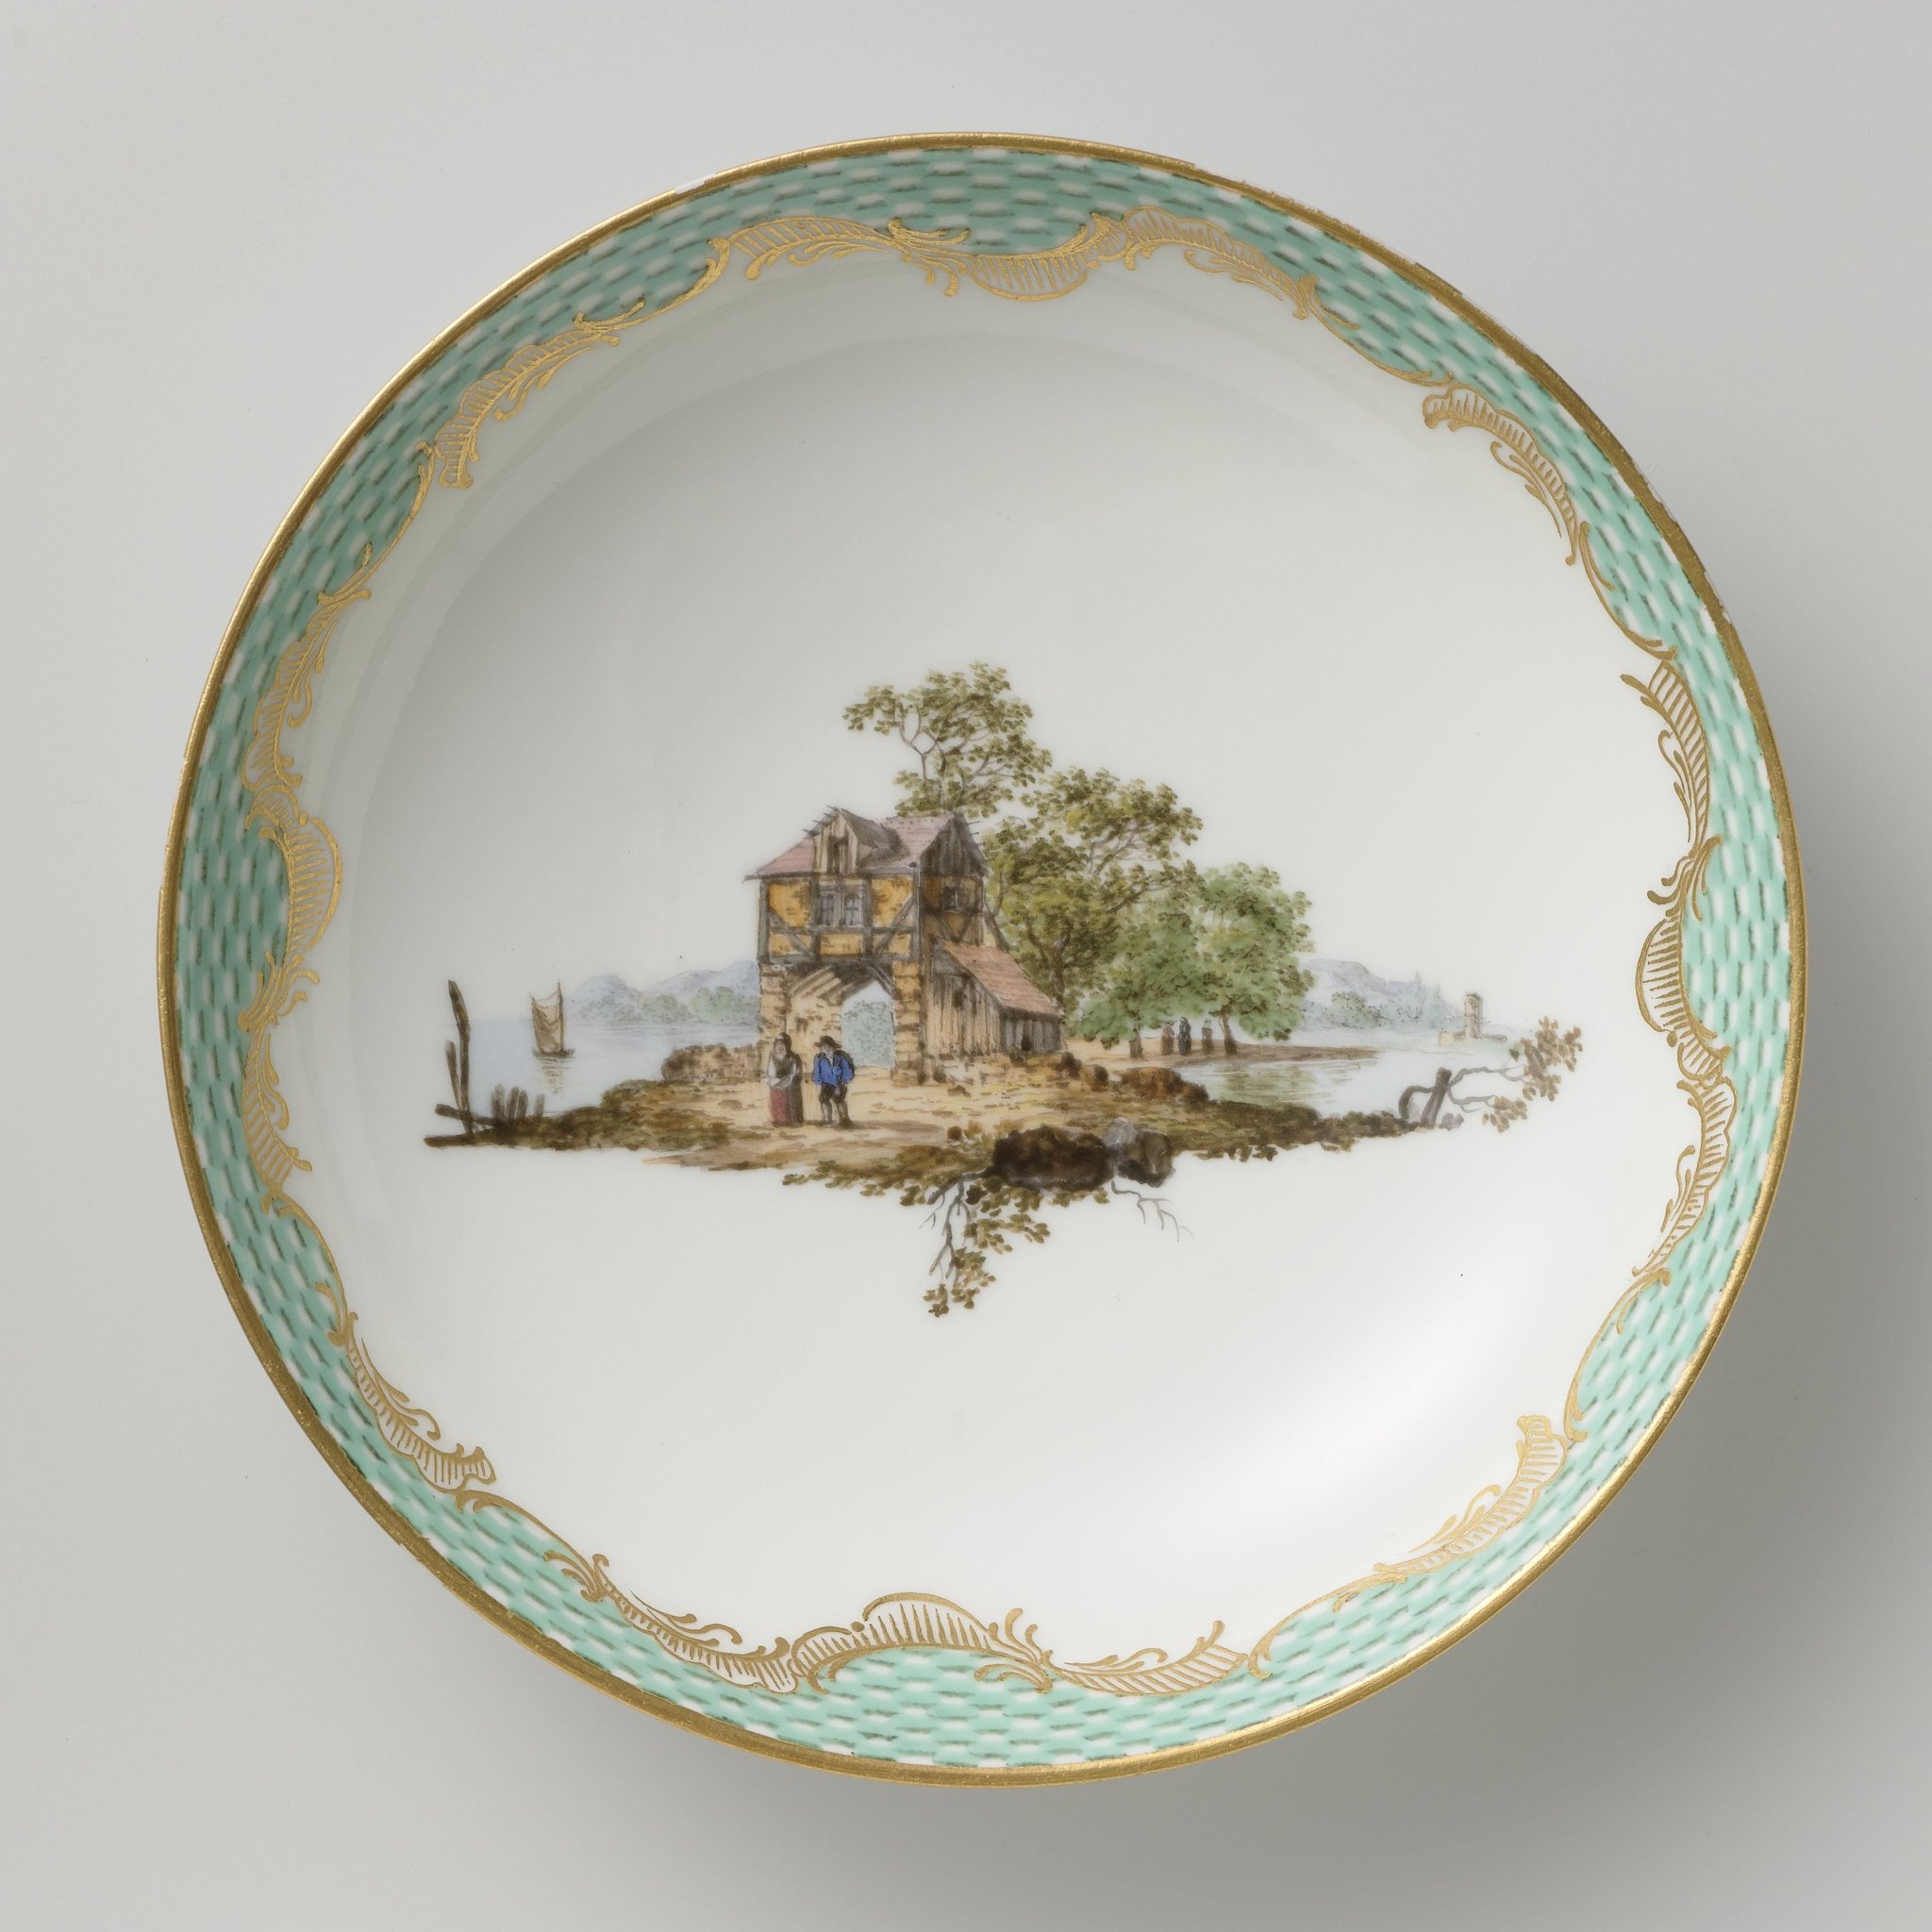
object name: platter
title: Schotel, veelkleurig beschilderd met een landschap met figuren.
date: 1777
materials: porcelain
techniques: painted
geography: meissen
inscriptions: factory mark, mold mark: ‘5’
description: Ronde schotel van beschilderd porselein. De schotel is beschilderd met landschappen waarin figuren en langs de rand een brede strook groen vlechtwerk. De schotel is gemerkt.